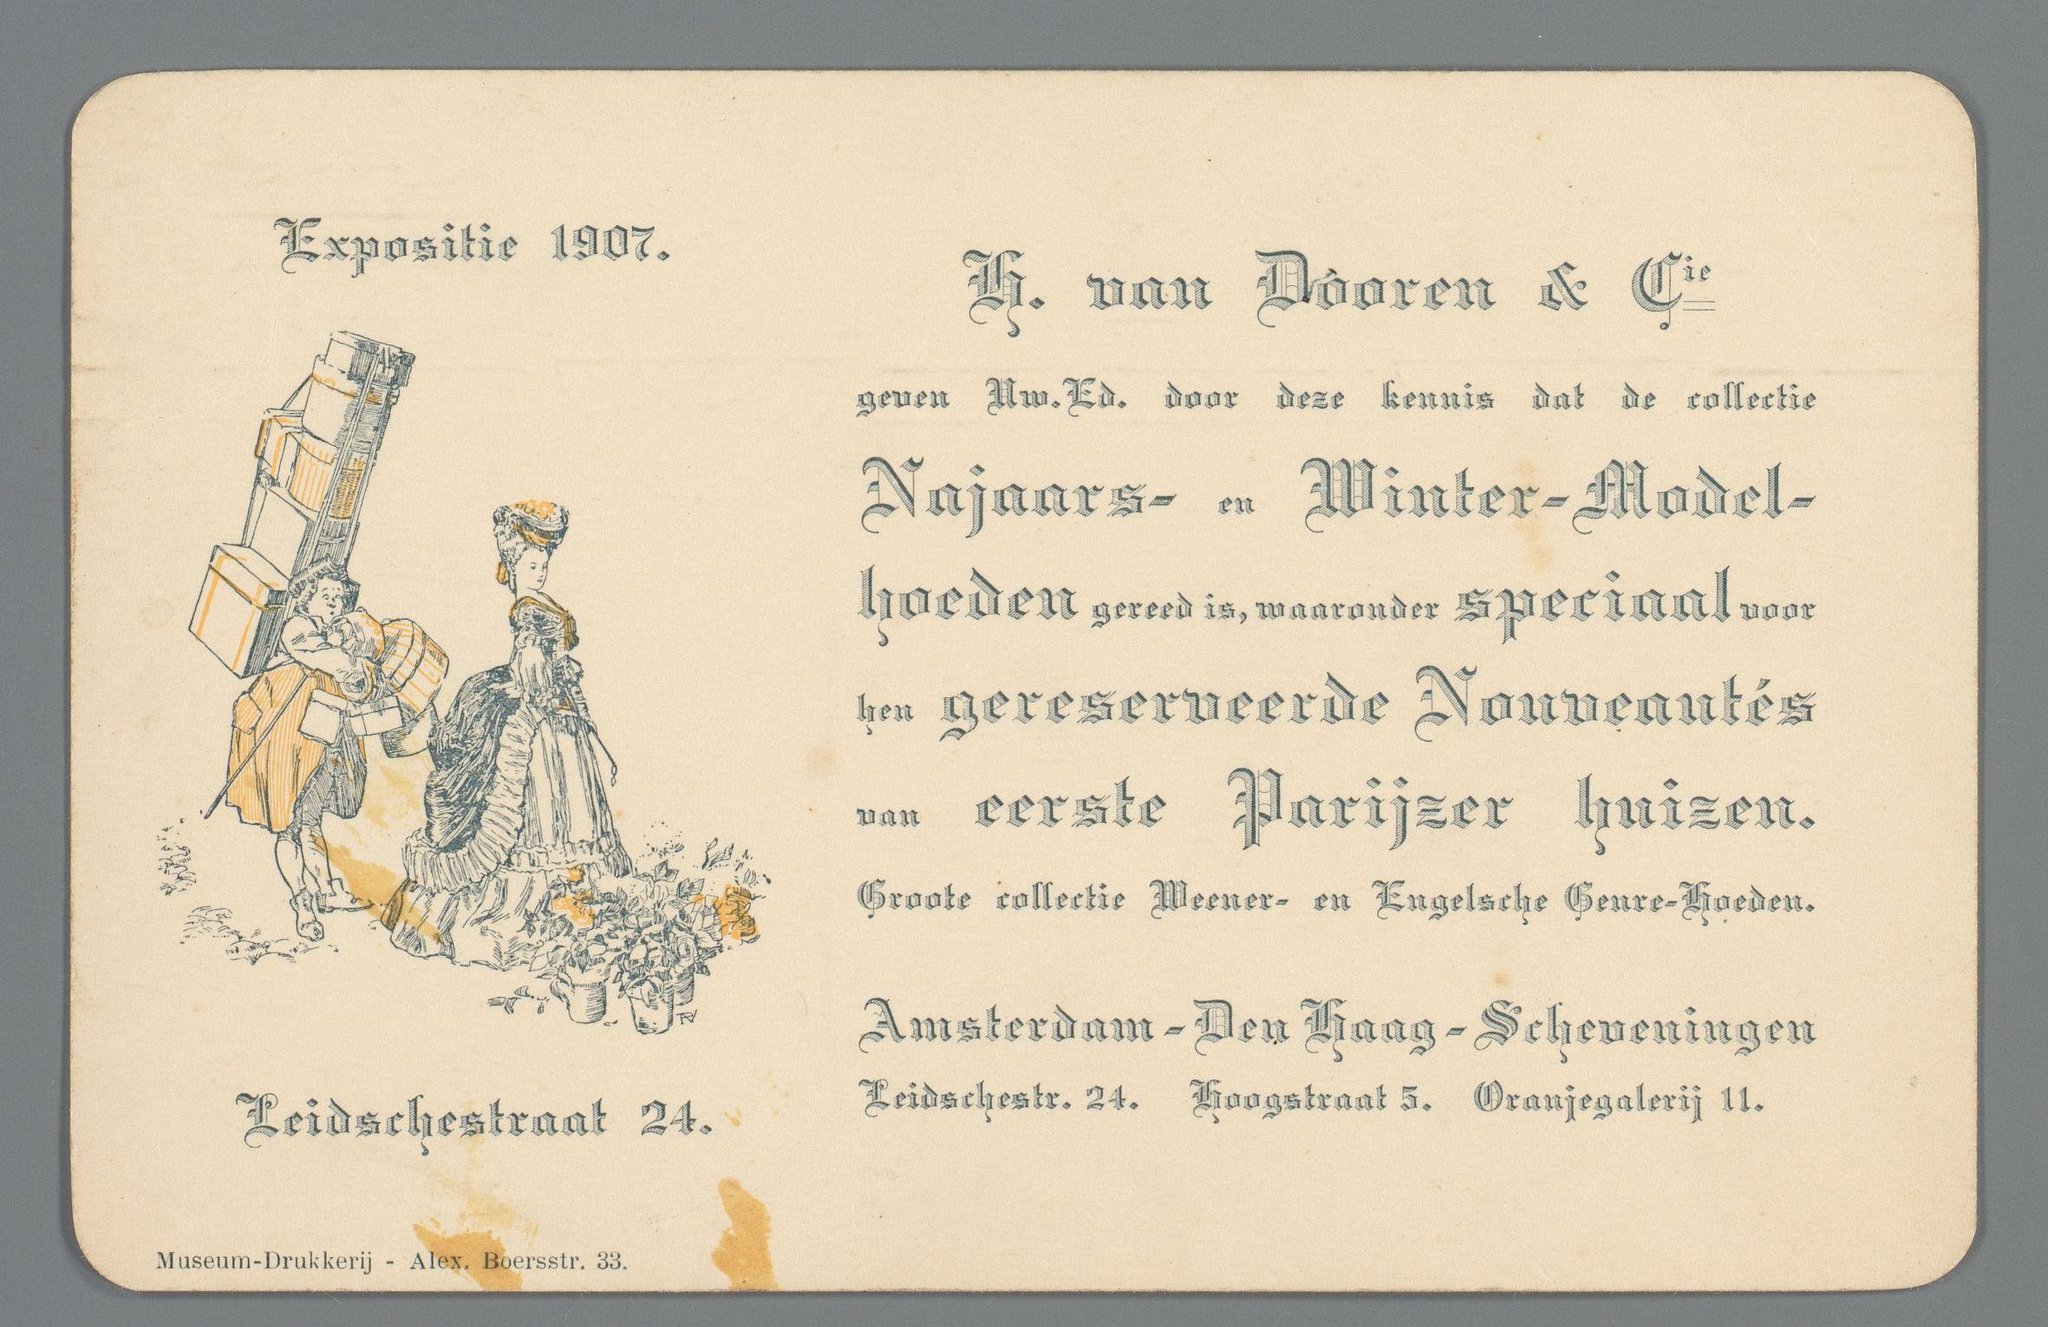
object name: invitation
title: Uitnodiging voor de nieuwe najaars- en wintercollectie hoeden van H. van Dooren & Cie.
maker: Anonymous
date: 1907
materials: paper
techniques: hand coloring, printing block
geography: amsterdam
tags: carrying something, fashionable woman, 'belle', amsterdam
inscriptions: annotation: ‘ingrediënten voor een 'Braeder recept'’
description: Links een deftig geklede vrouw met daarachter een man die talloze dozen draagt en op zijn rug gebonden heeft. Rechts de tekst: 'H. van Dooren & Cie. geven Uw.Ed. door deze kennis dat de collectie Najaars- en Winter-modelhoeden gereed is, waaronder speciaal voor hen gereserveerde Nouveautés van eerste Parijzer huizen. Groote collectie Weener- en Engelsche Genre-hoeden'.